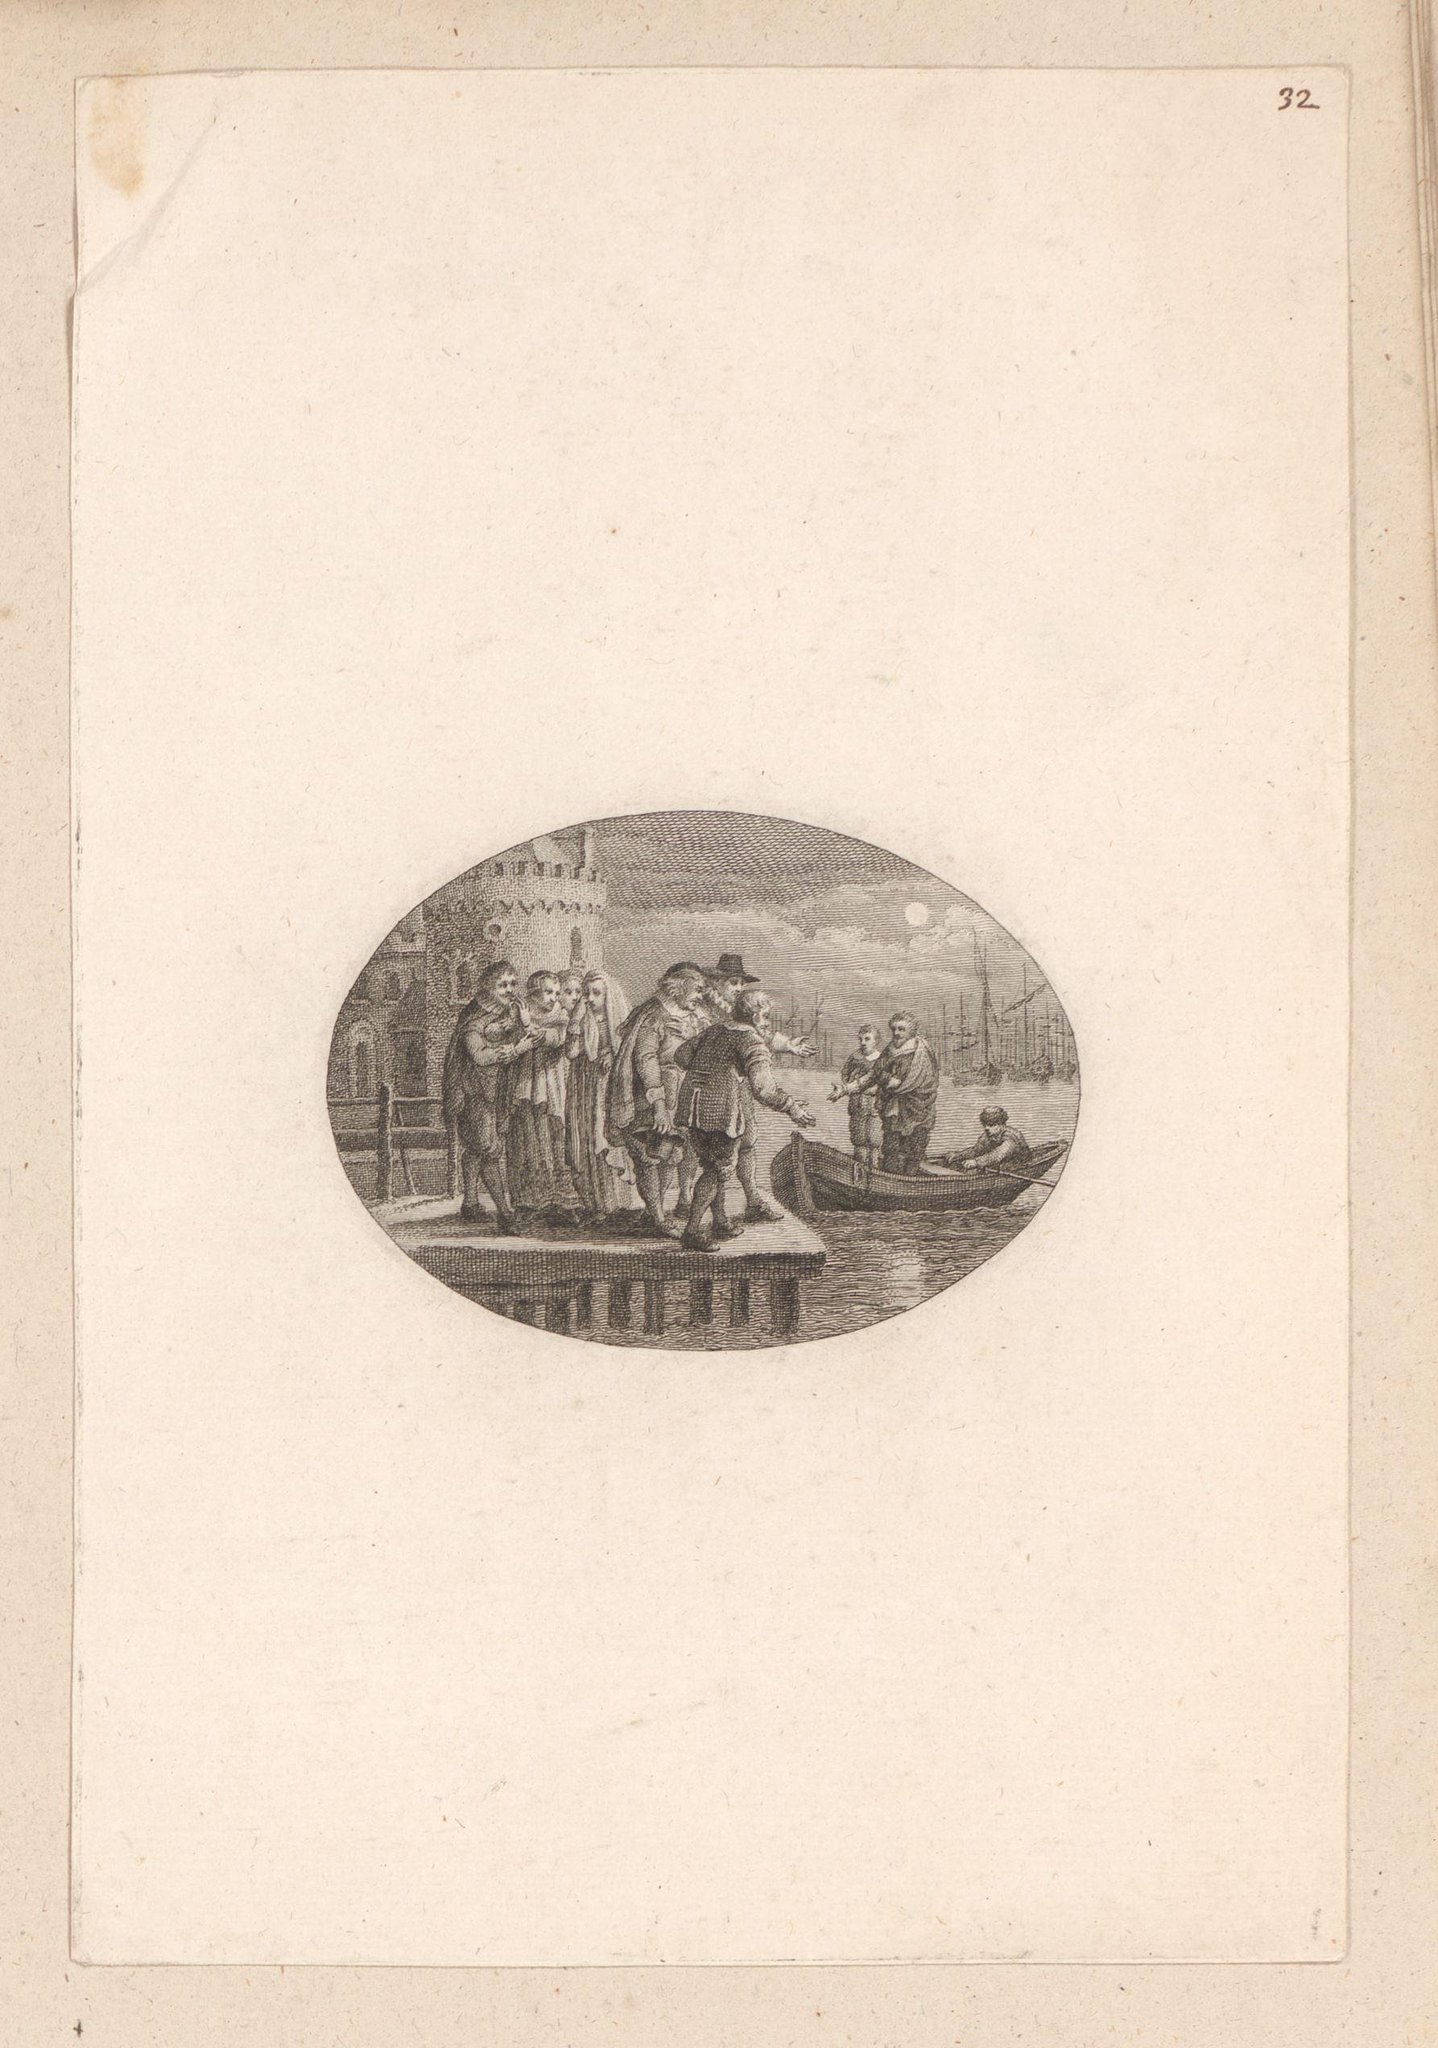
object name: print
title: Vlucht van Hugo de Groot uit Amsterdam in 1632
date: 1808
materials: paper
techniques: engraving, etching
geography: haarlem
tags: hugo de groot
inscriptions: inscription: ‘32’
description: De vlucht van Hugo de Groot uit Amsterdam in de nacht van 14 april 1632. Hugo de Goot vaart in een roeibootje weg van de kade bij de Schreierstoren. Familie en vrienden nemen afscheid. De prent maakt deel uit van een album.